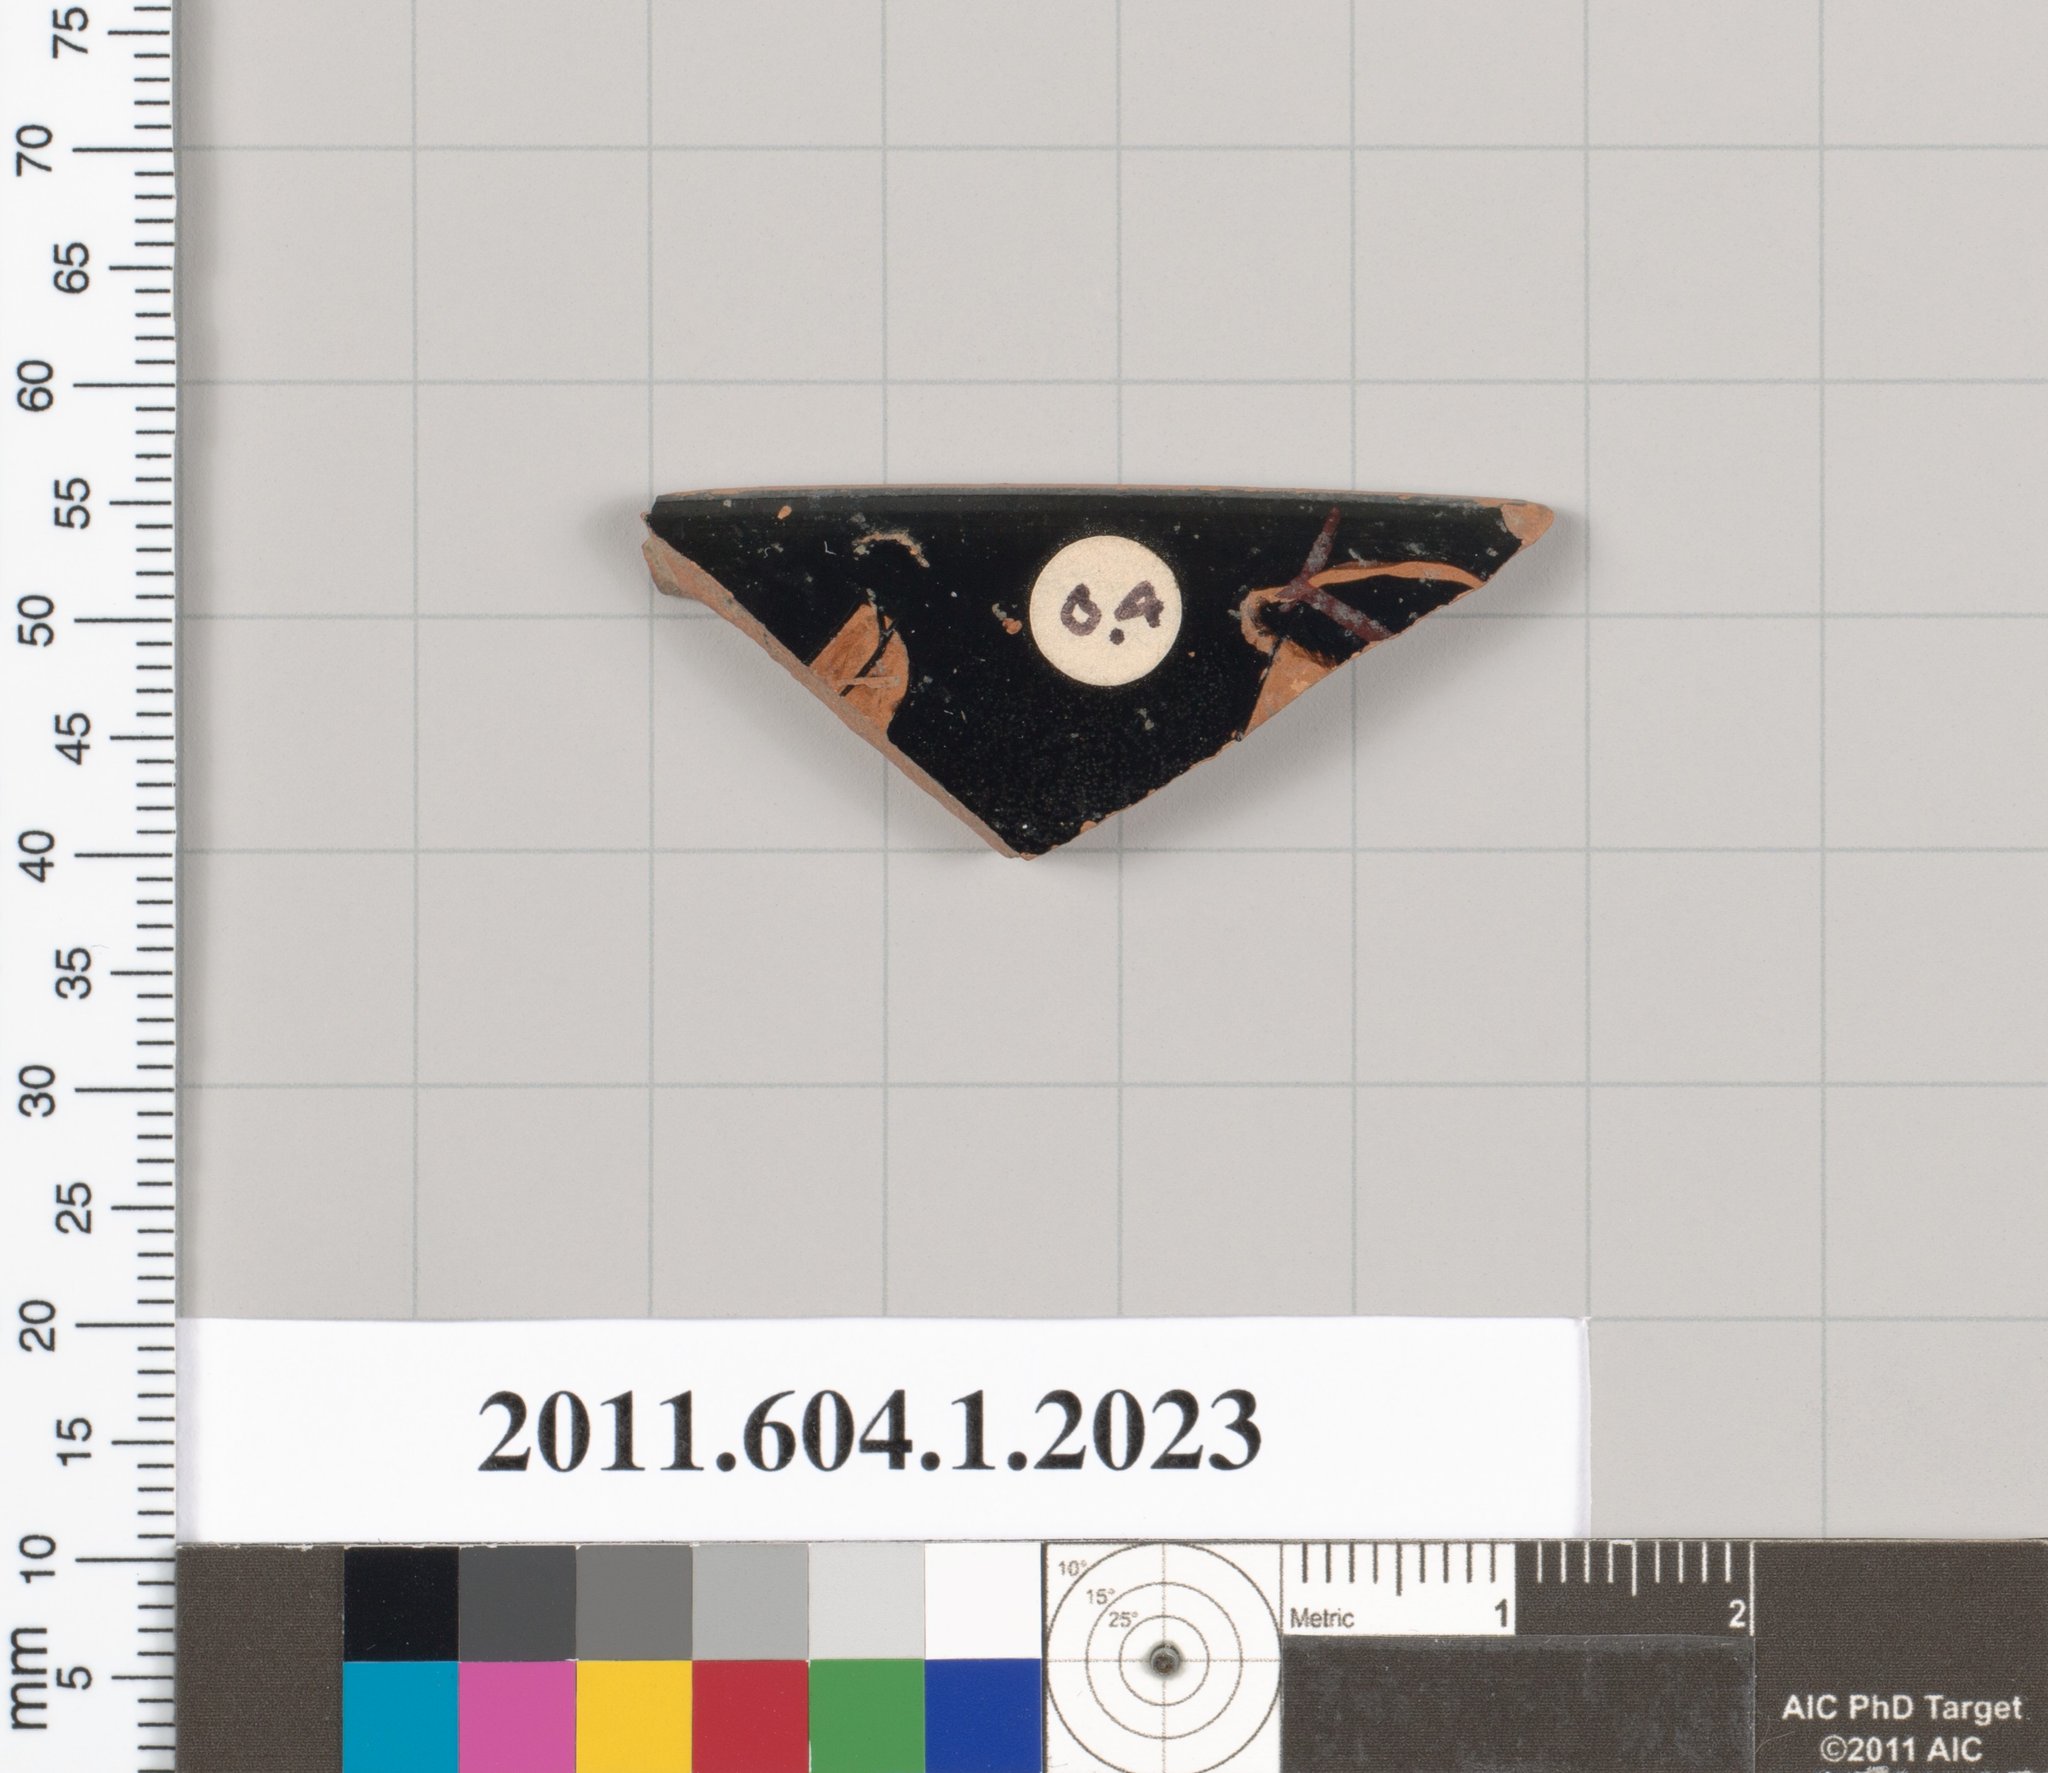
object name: kylix fragment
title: Terracotta rim fragment of a kylix (drinking cup)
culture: greek, attic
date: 475-451 BCE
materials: terracotta